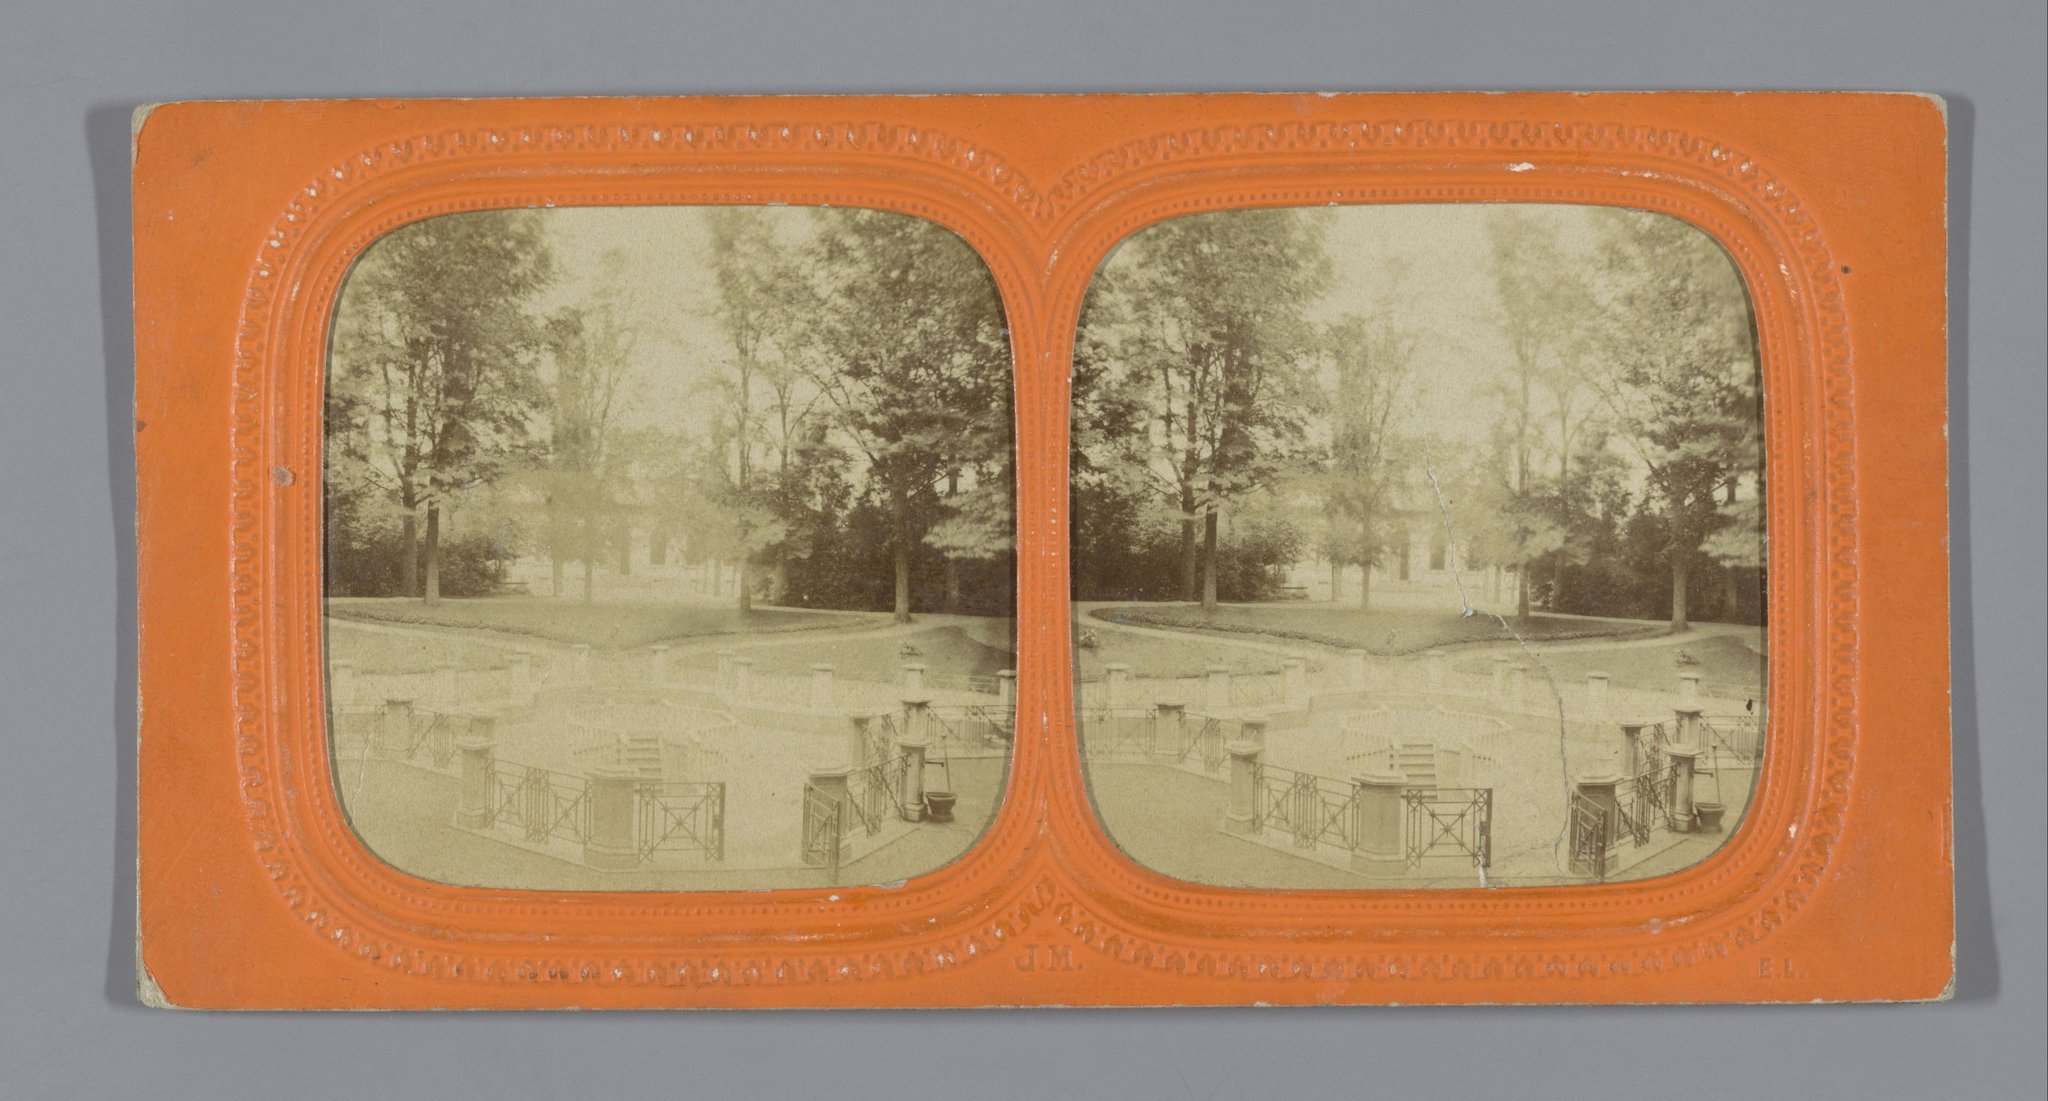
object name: tissue stereograph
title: Louissenbrunnen in Bad Homburg, Duitsland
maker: jules marinier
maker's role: publisher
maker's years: 1823-1896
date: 1864-1879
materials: cardboard, paper, photographic support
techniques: albumen print, hand coloring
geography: bad homburg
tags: spring, source of river or stream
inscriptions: number: ‘15’, inscription: ‘defr’, monogram: ‘E.L.’, monogram: ‘J.M.’